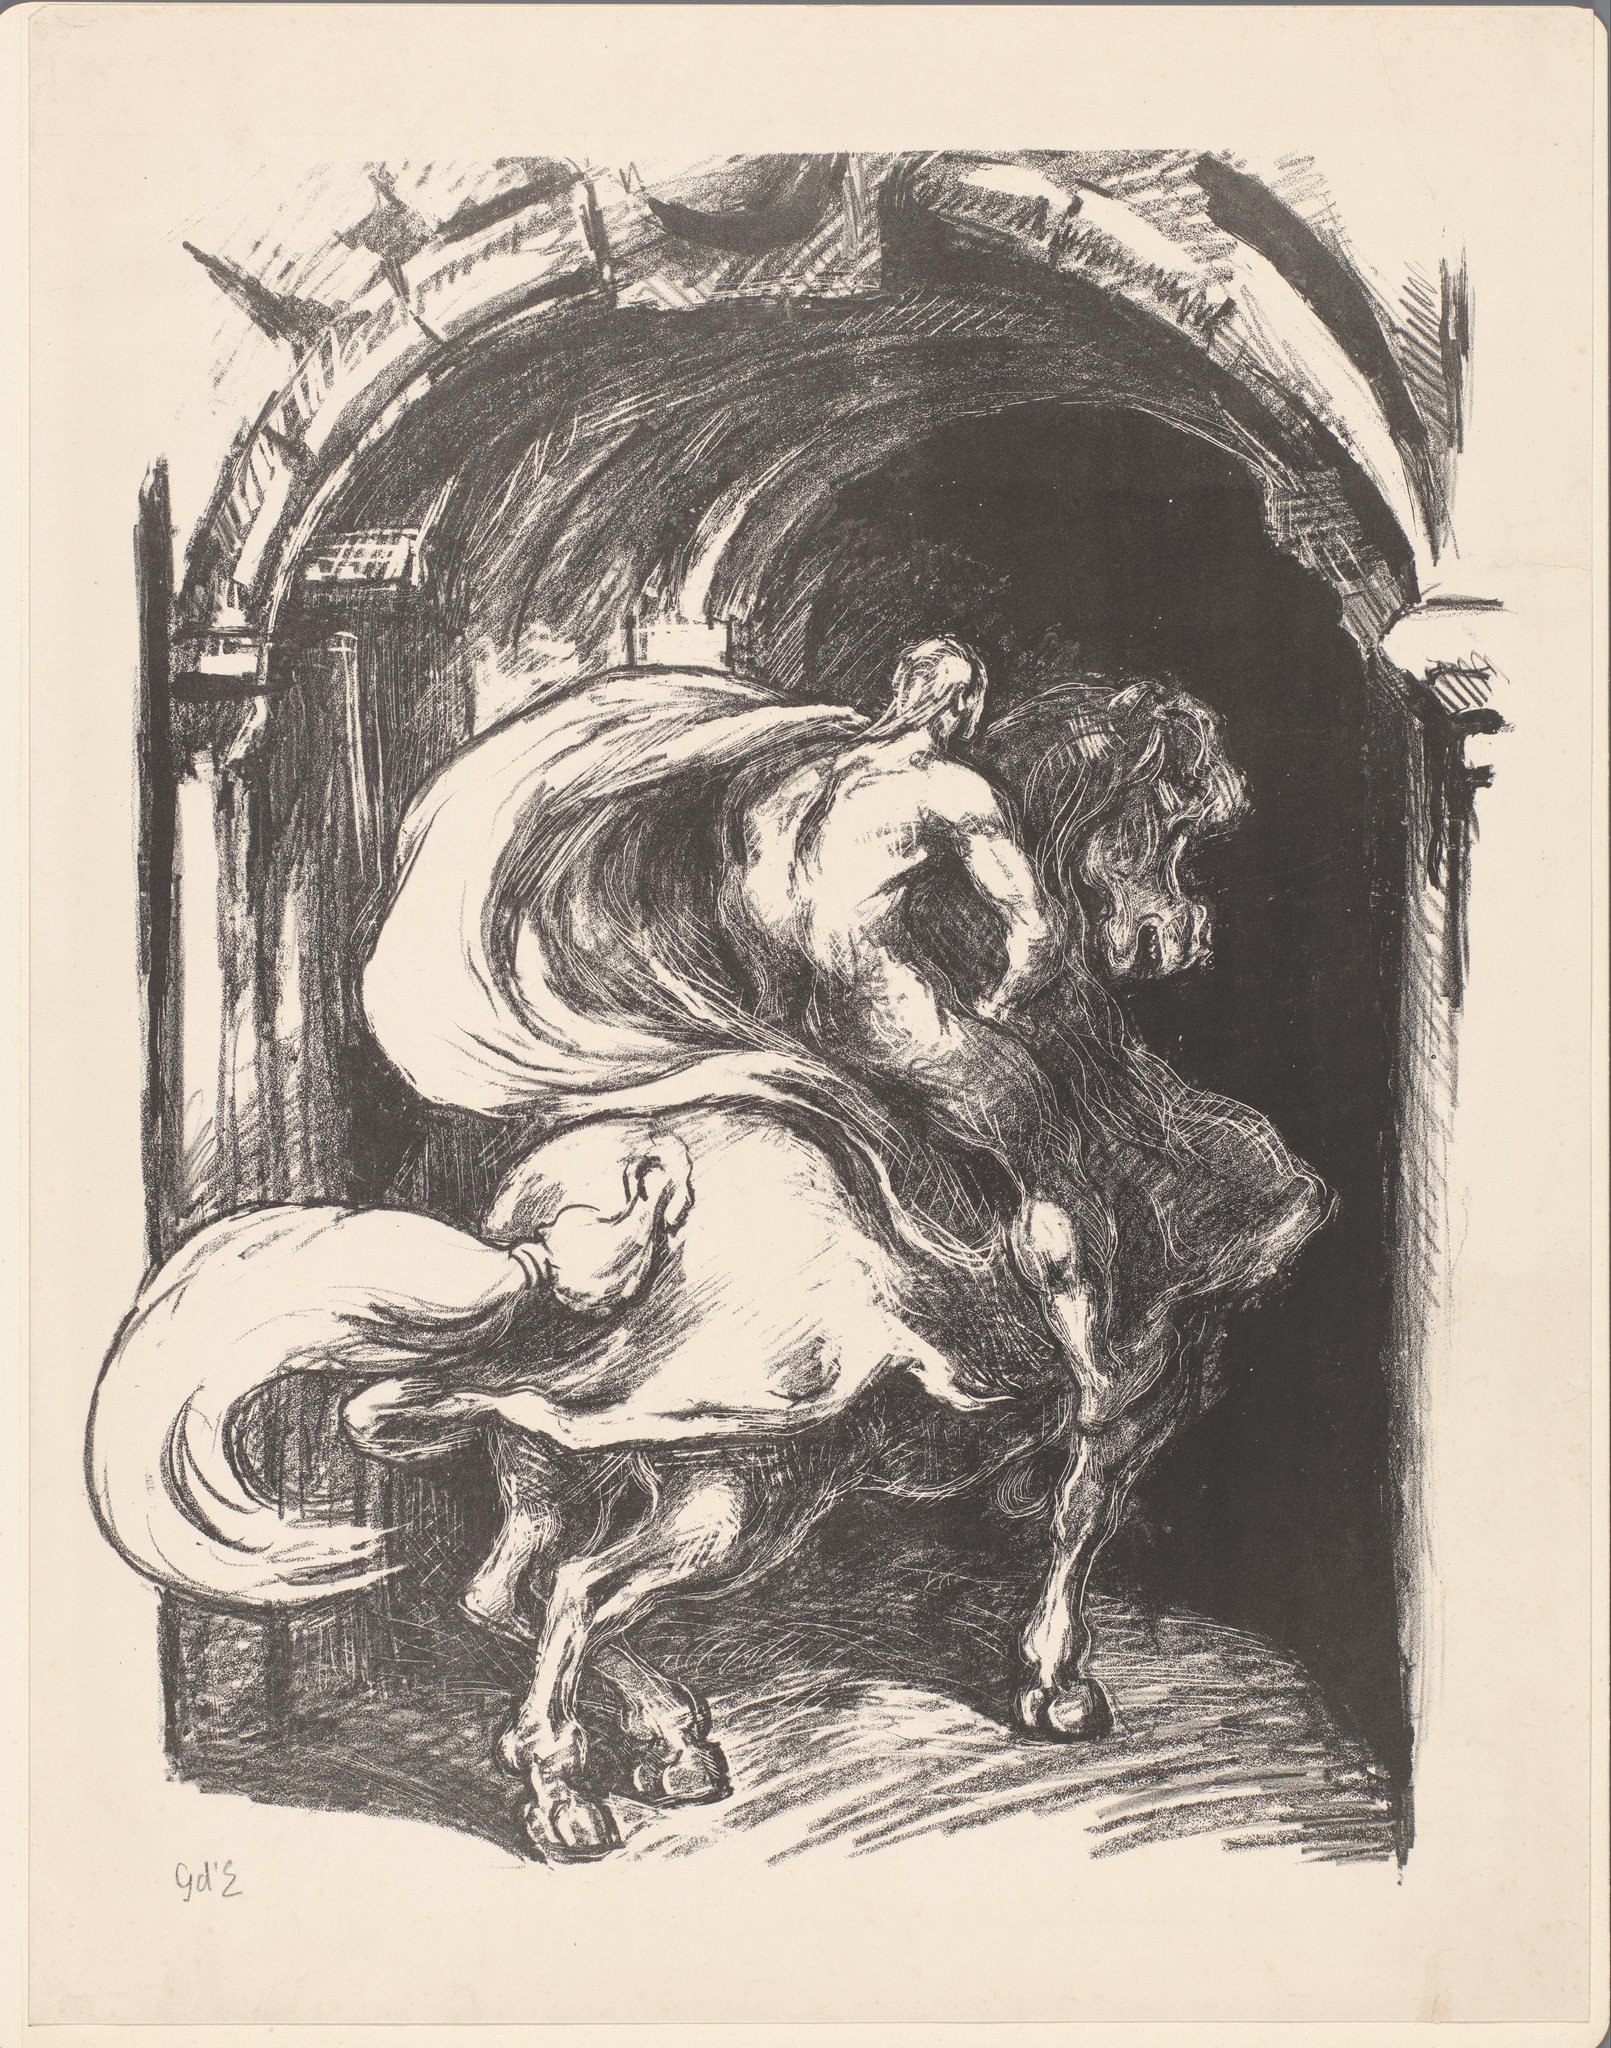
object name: print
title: Ruiter rijdt een poort binnen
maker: georges d espagnat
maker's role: print maker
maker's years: 1870-1950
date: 1895-1930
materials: paper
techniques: lithograph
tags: riding a horse, ass, or mule; rider, horseman, gate, entrance, village-gate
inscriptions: collector's mark: Lugt 2228a